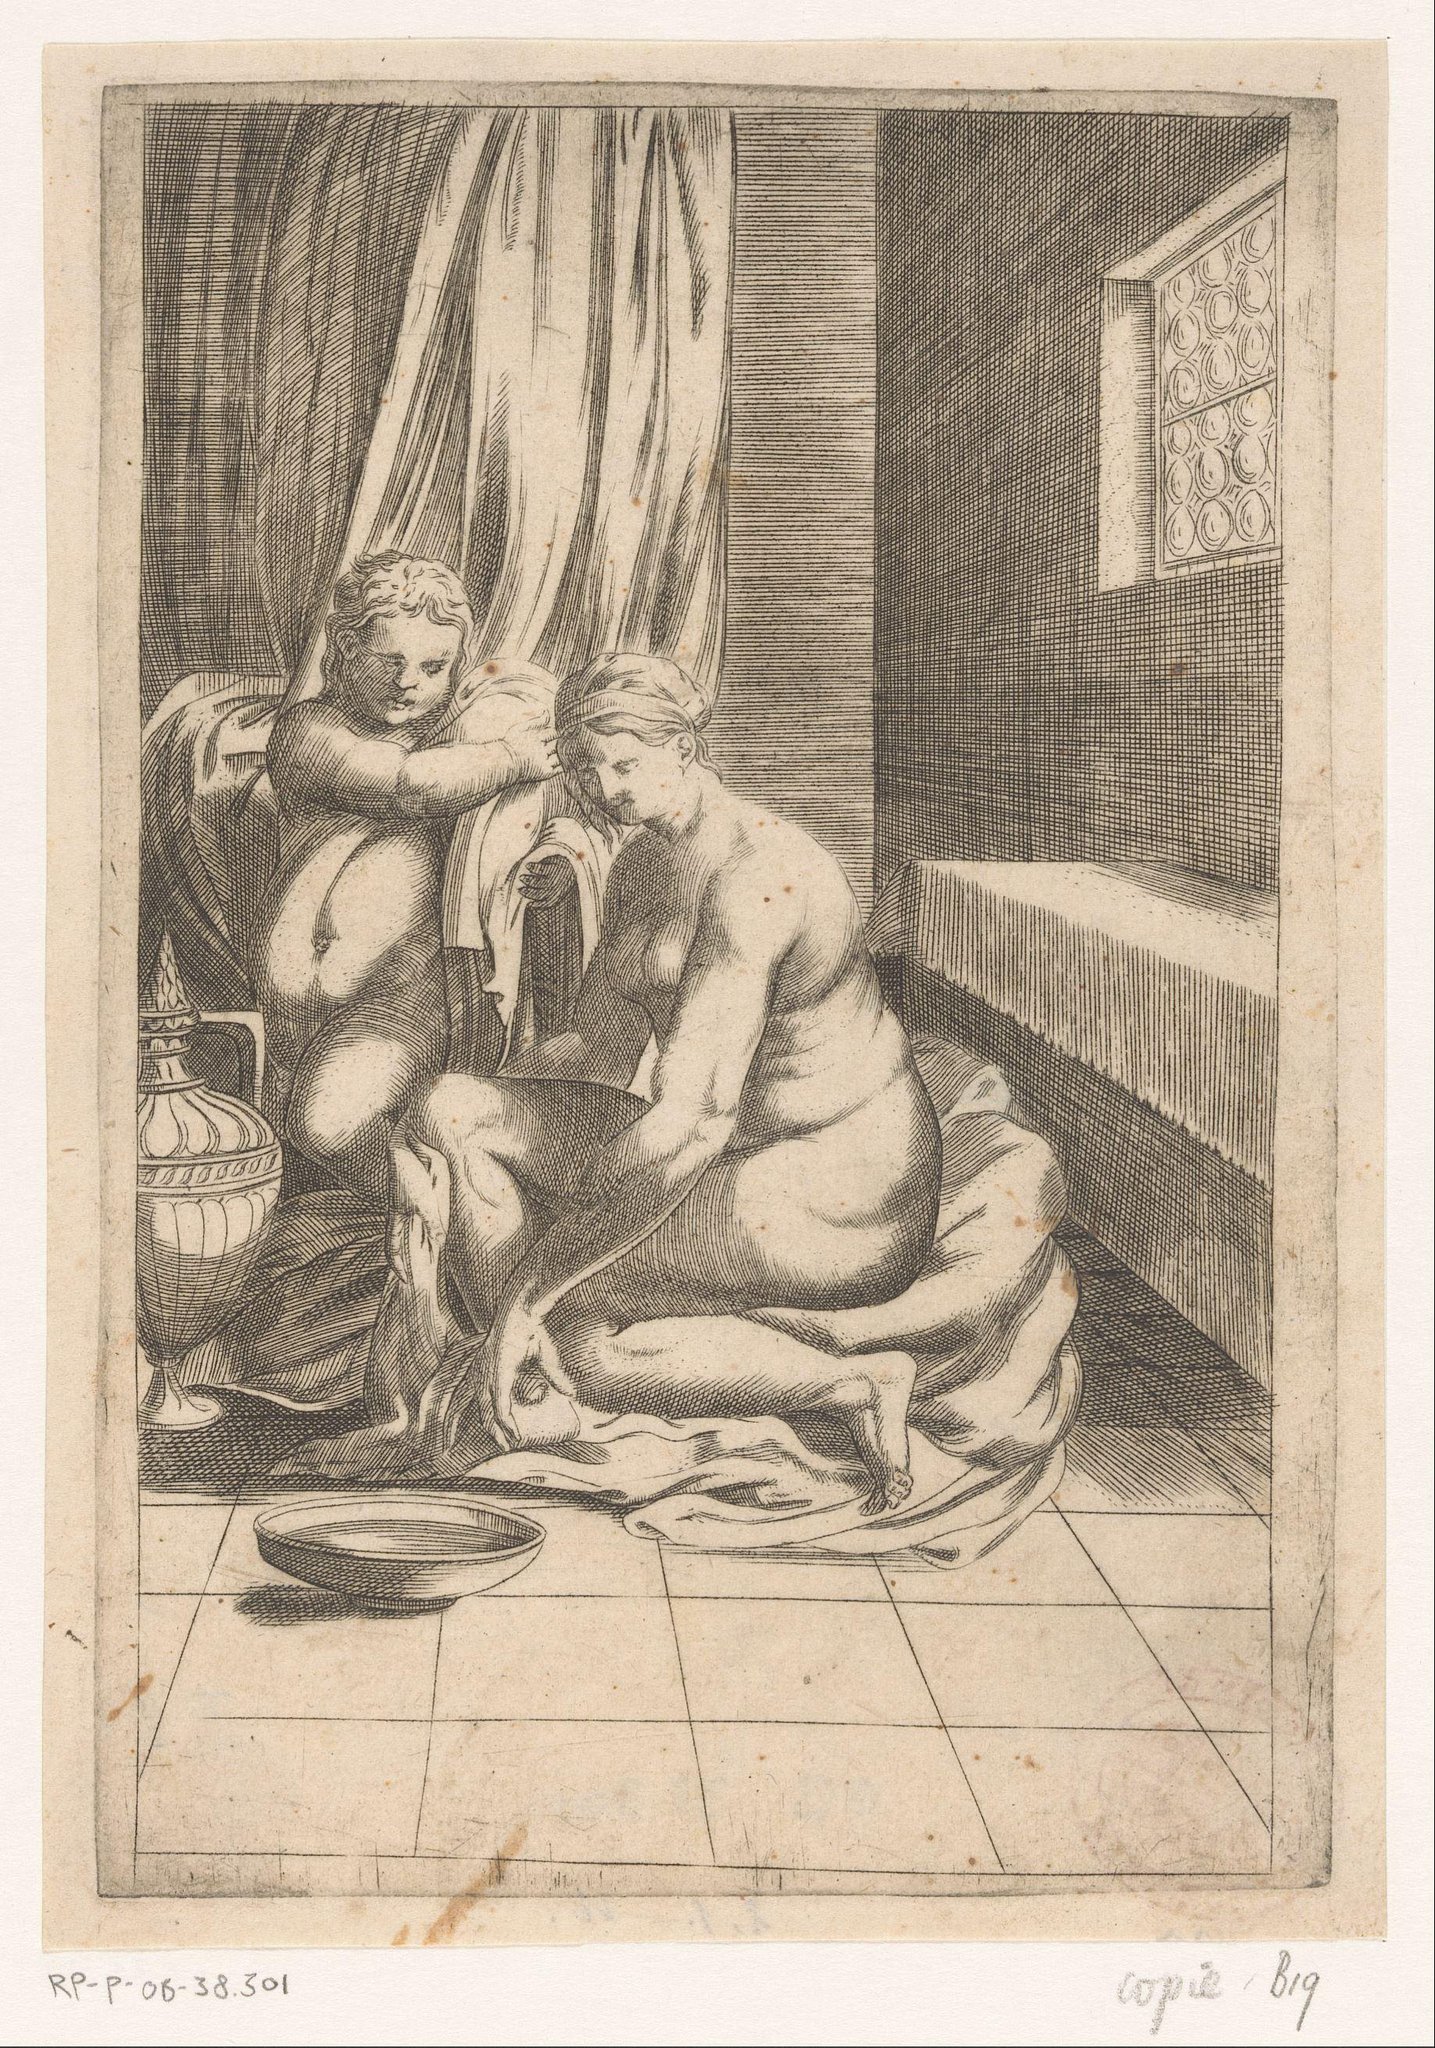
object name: print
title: Toilet van Venus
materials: paper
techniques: engraving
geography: italy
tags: toilet of venus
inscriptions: inscription: ‘2.1. - 66.’, collector's mark: Lugt 240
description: Venus droogt zich af na een bad. Links staat Amor.